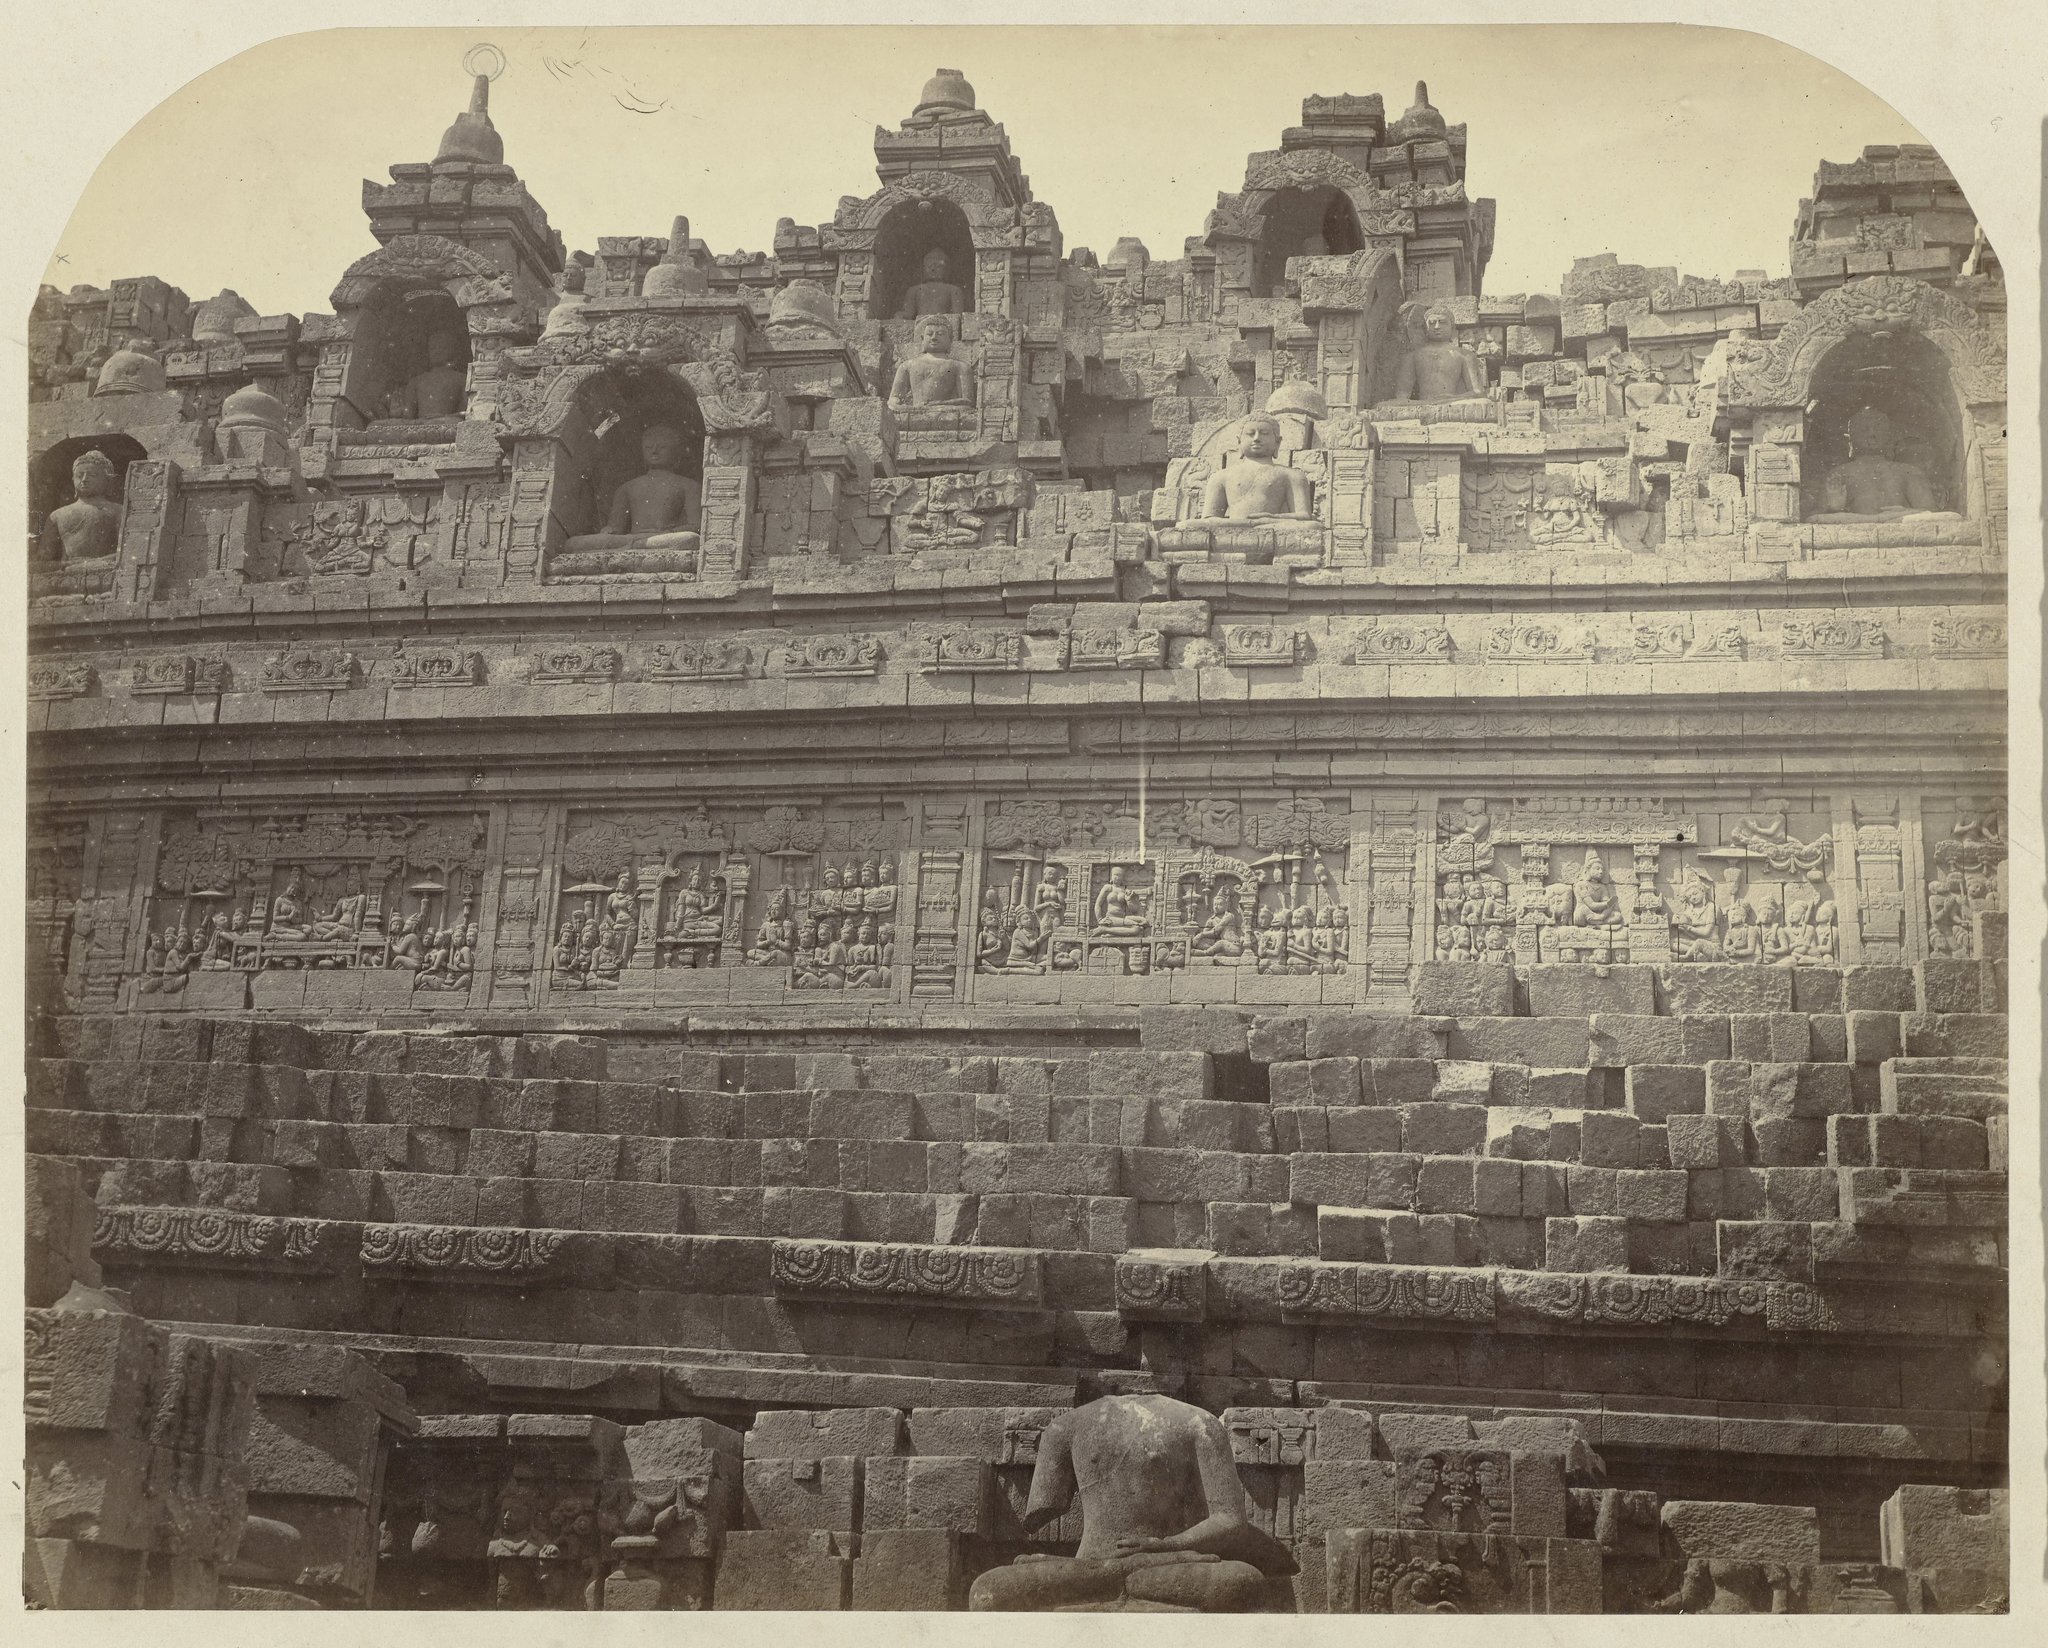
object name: photograph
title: Zicht op de noordzijde van de Borobudur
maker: isidore kinsbergen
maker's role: fotograaf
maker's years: 1821-1905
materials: cardboard, paper, photographic support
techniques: albumen print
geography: java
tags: borobudur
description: General view of the north side, showing the reliefs on the outer wall of the 'balustrade' and some of the 432 niches containing Buddha statues. Borobudur village, Magelang district, Central Java province, 778-824 AD.